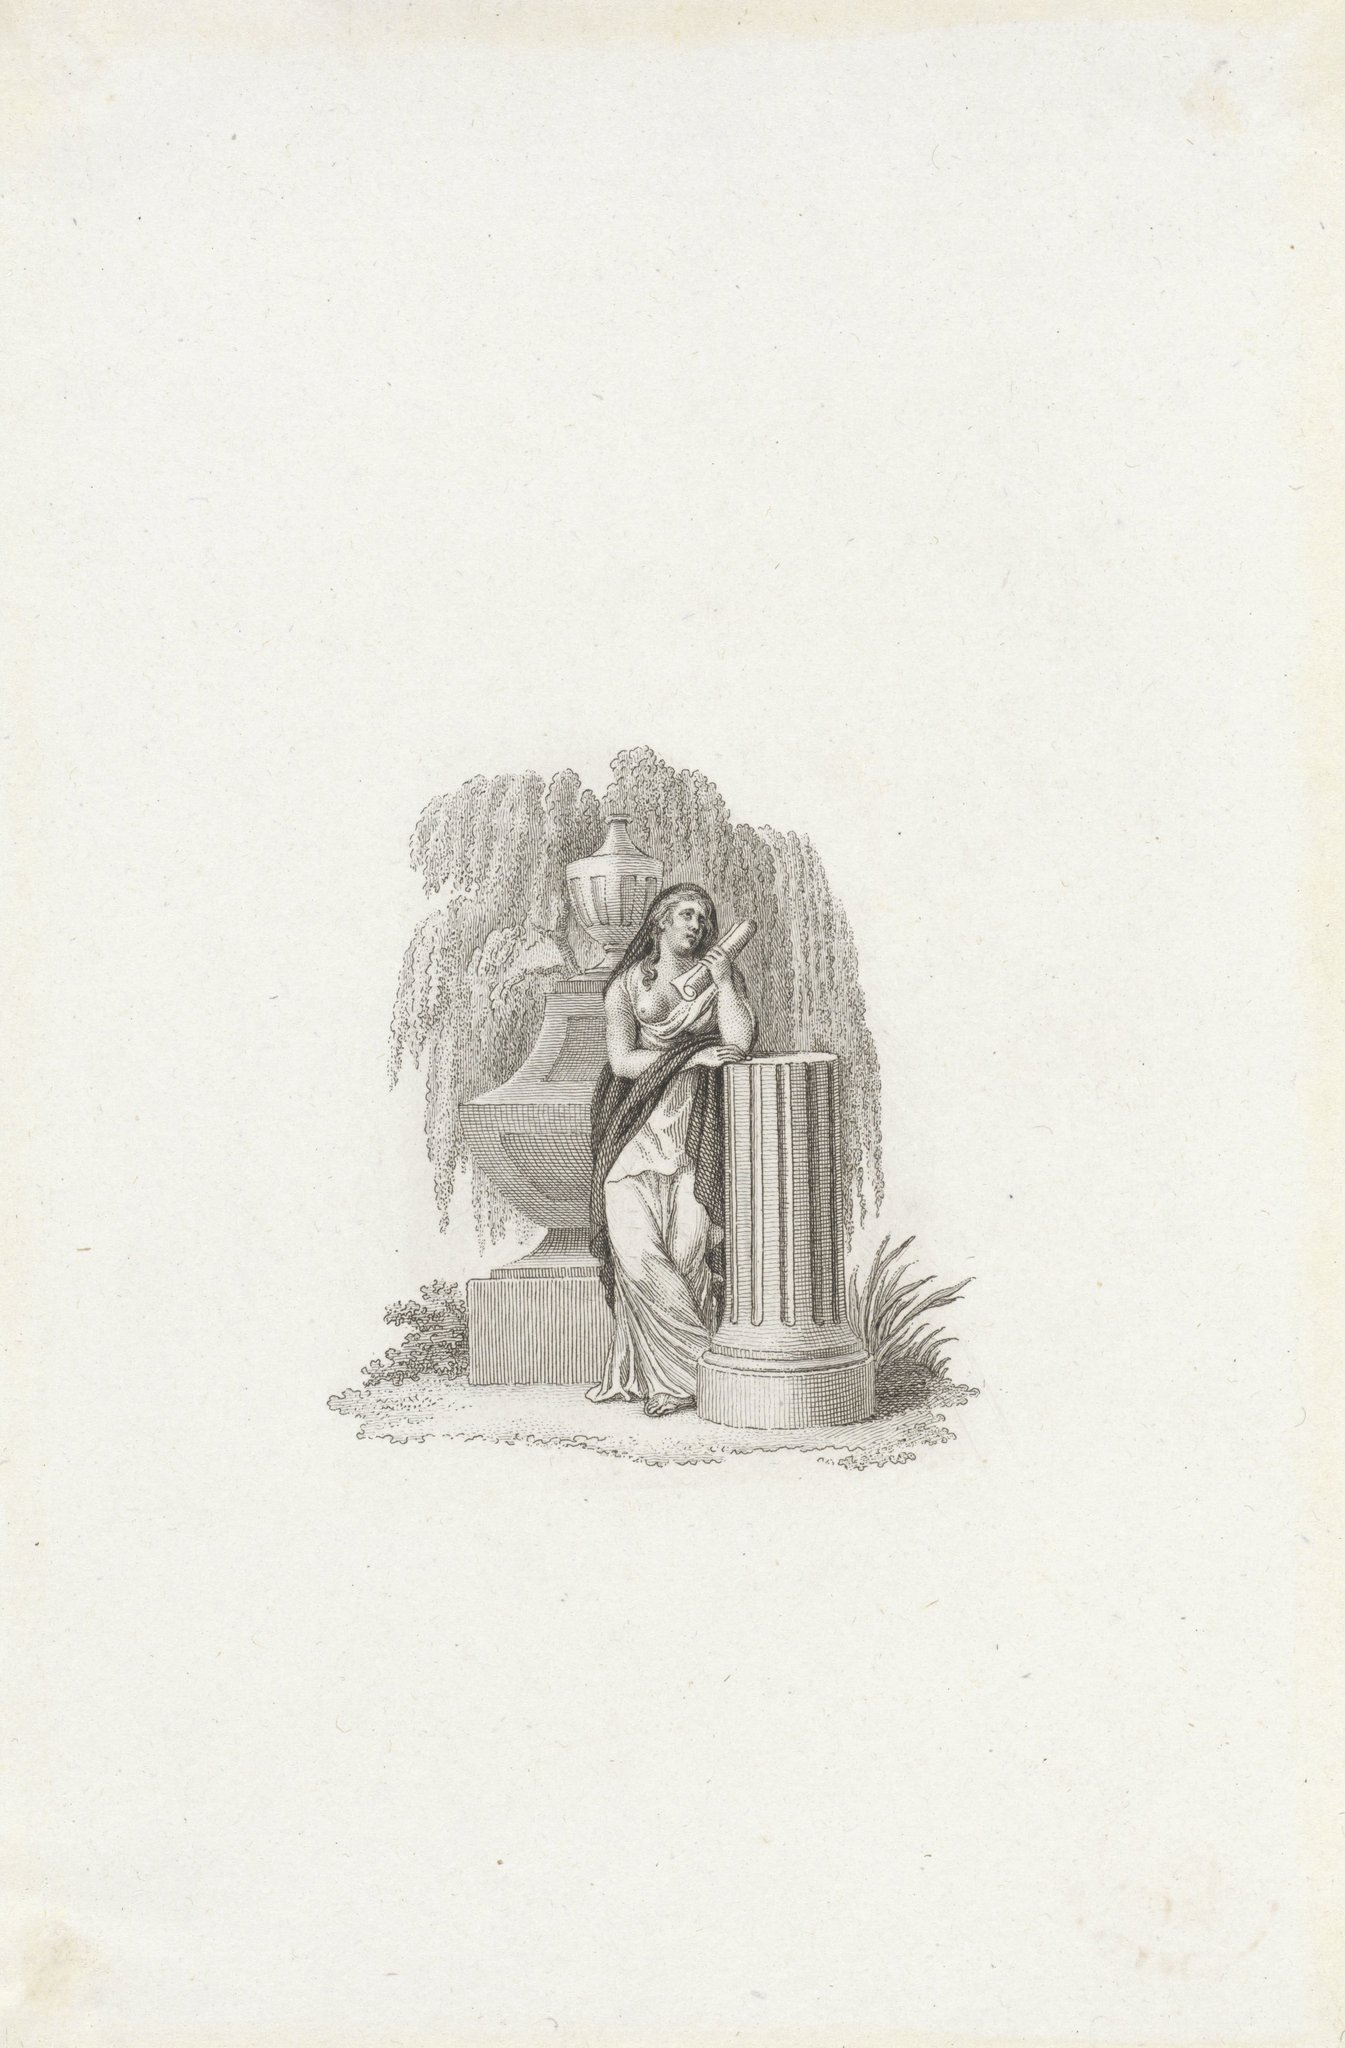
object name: print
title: Vignet met treurende vrouw bij een grafmonument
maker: reinier vinkeles (i)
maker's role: draughtsman, print maker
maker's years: 1741-1816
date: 1751-1816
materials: paper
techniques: etching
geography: amsterdam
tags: mourning the dead, grave-building, monumental tomb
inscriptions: collector's mark: Lugt 240